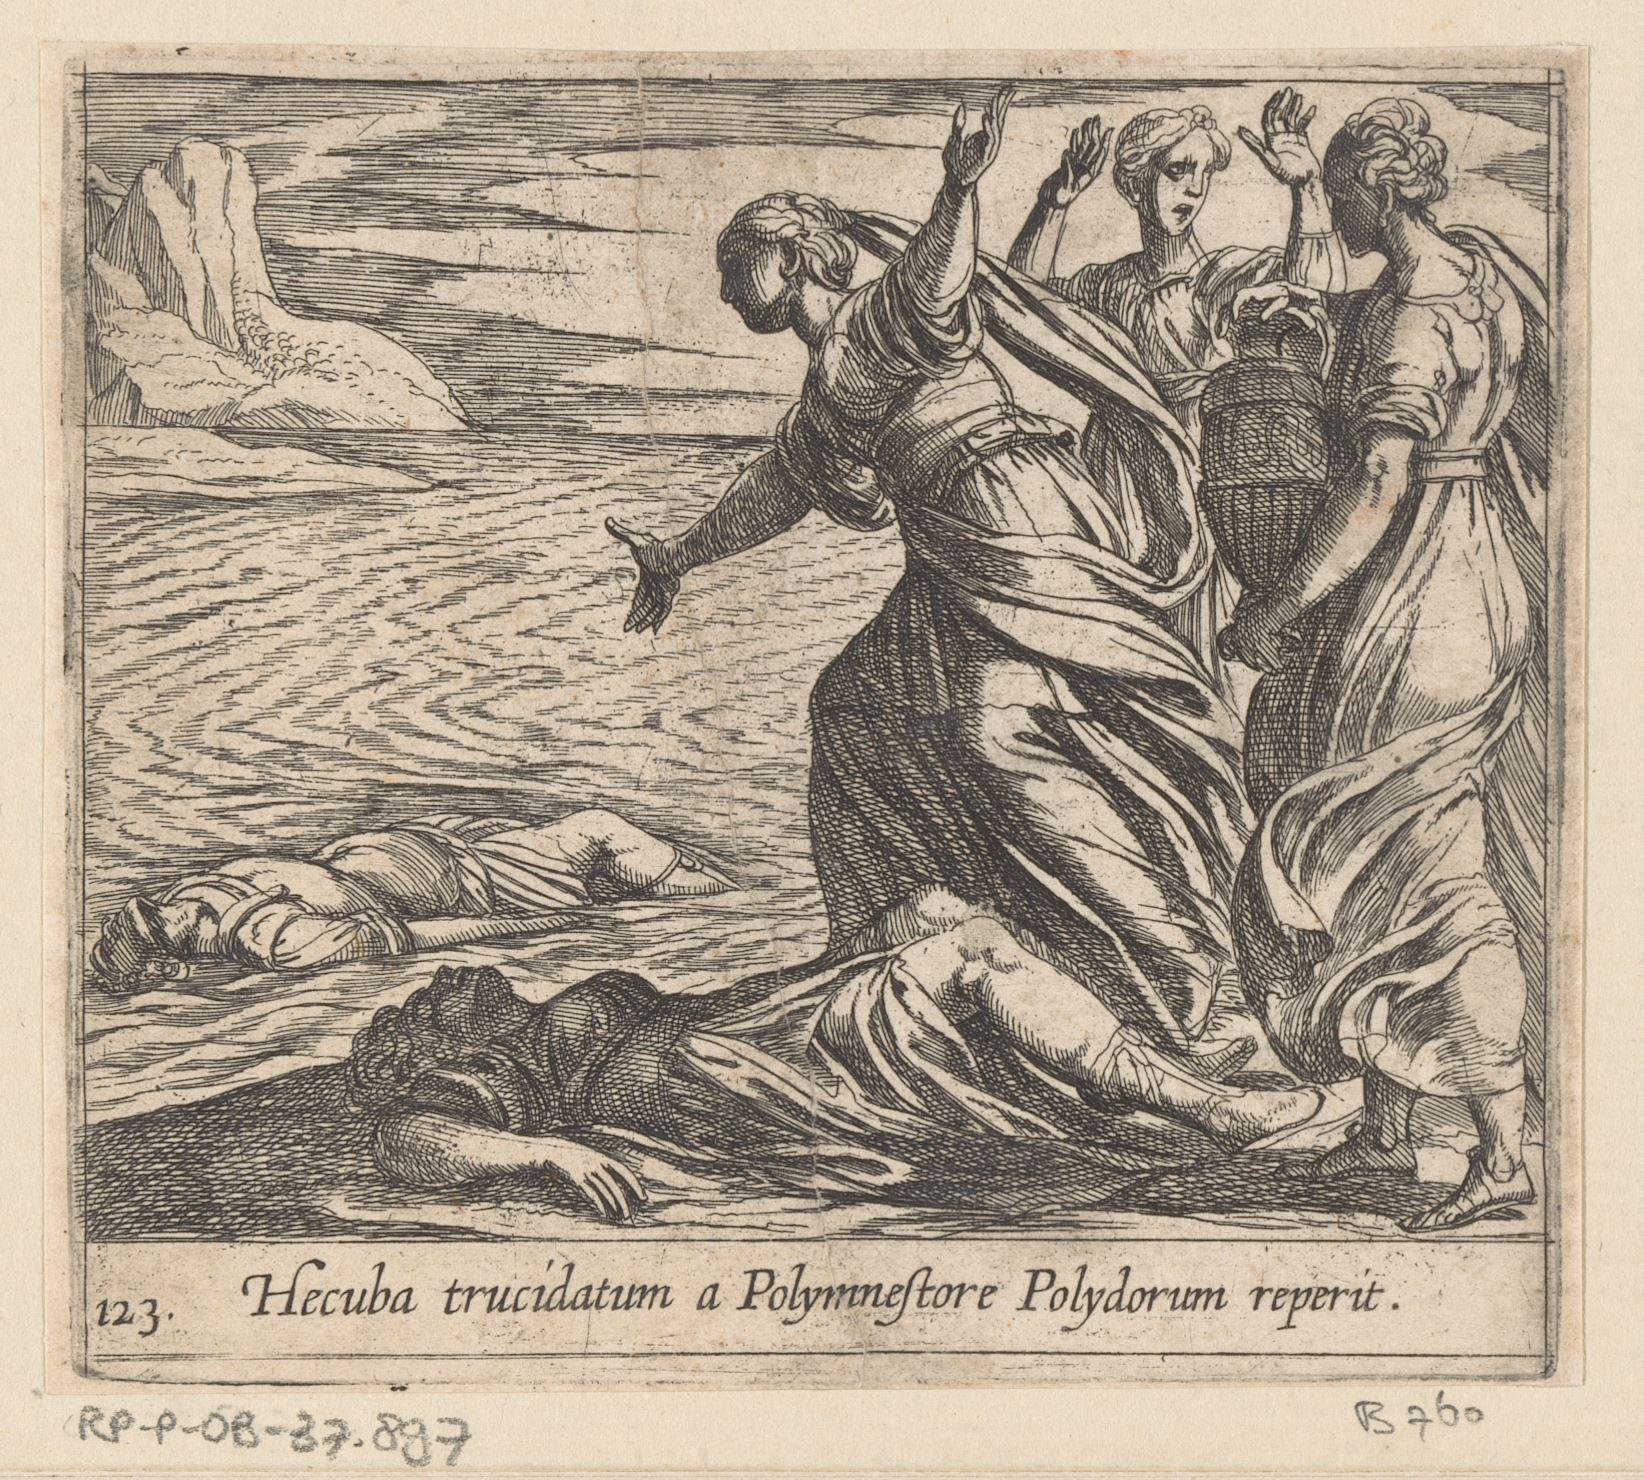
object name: print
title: Metamorfosen van Ovidius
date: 1606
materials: paper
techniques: etching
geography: antwerp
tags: hecuba finds her dead son polydorus on the sea-shore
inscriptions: collector's mark: Lugt 240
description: Deze prent maakt deel uit van een reeks van 150 prenten (+ titelprent) met voorstellingen van de Metamorfosen van Ovidius.